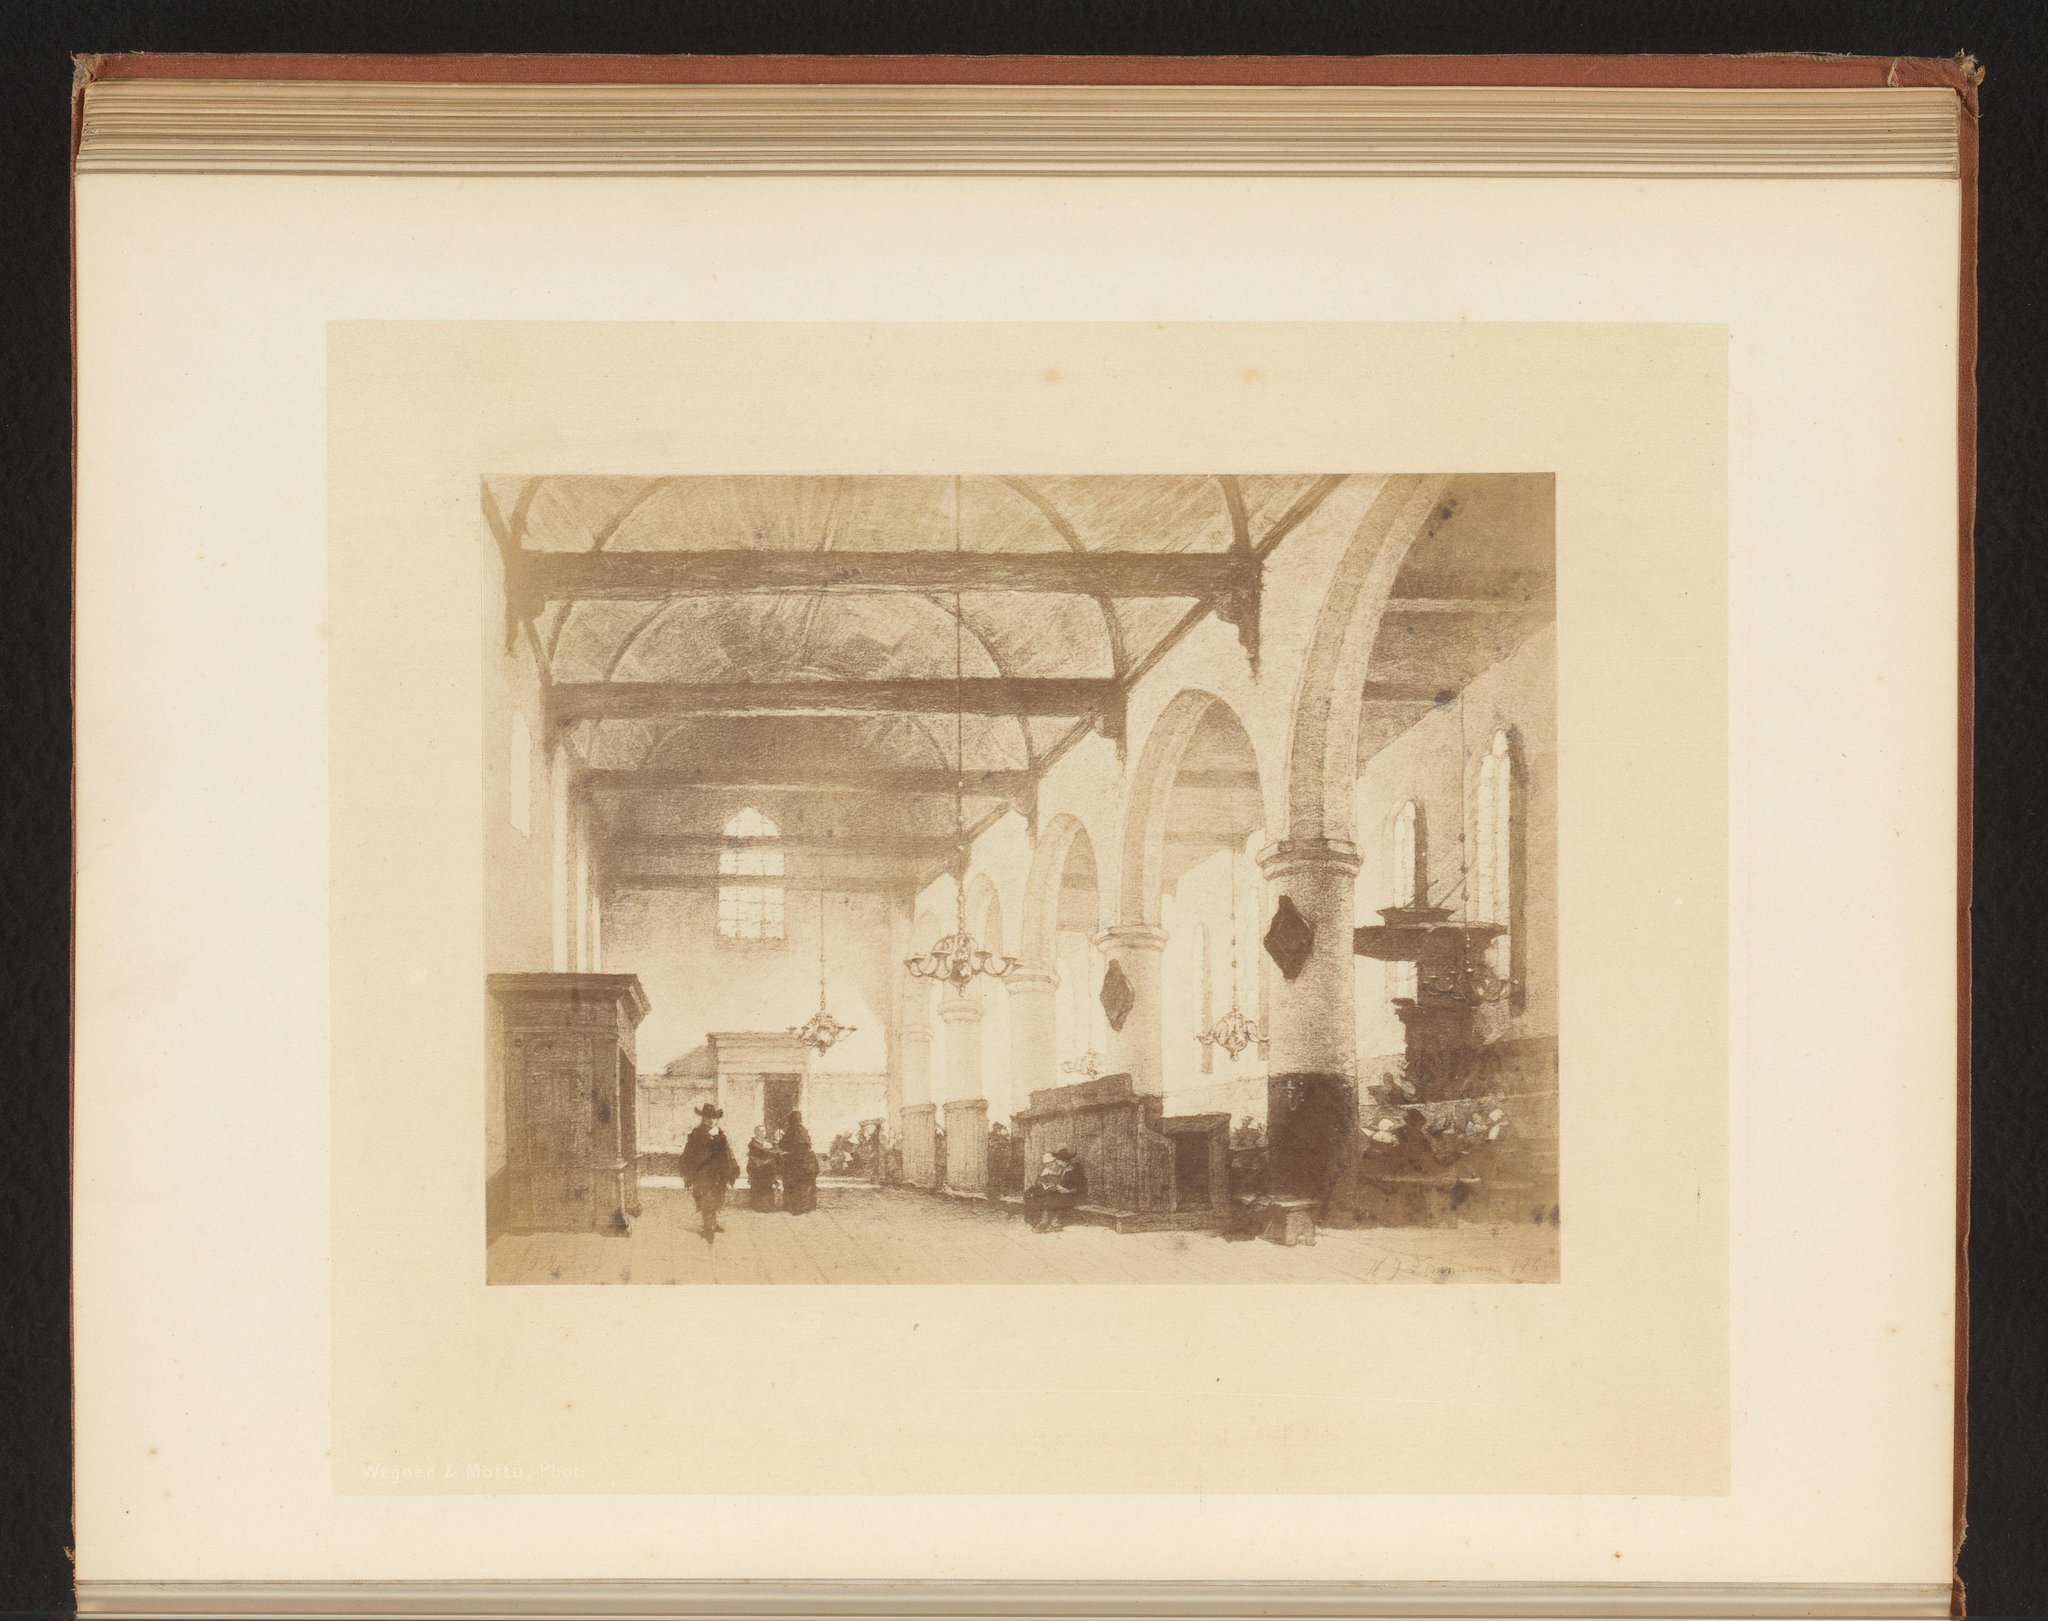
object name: page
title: Fotoreproductie van een gravure naar een schilderij van een kerkinterieur door Johannes Bosboom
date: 1866-1871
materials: paper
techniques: albumen print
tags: print, e.g.: engraving, etching, lithograph, interior of church